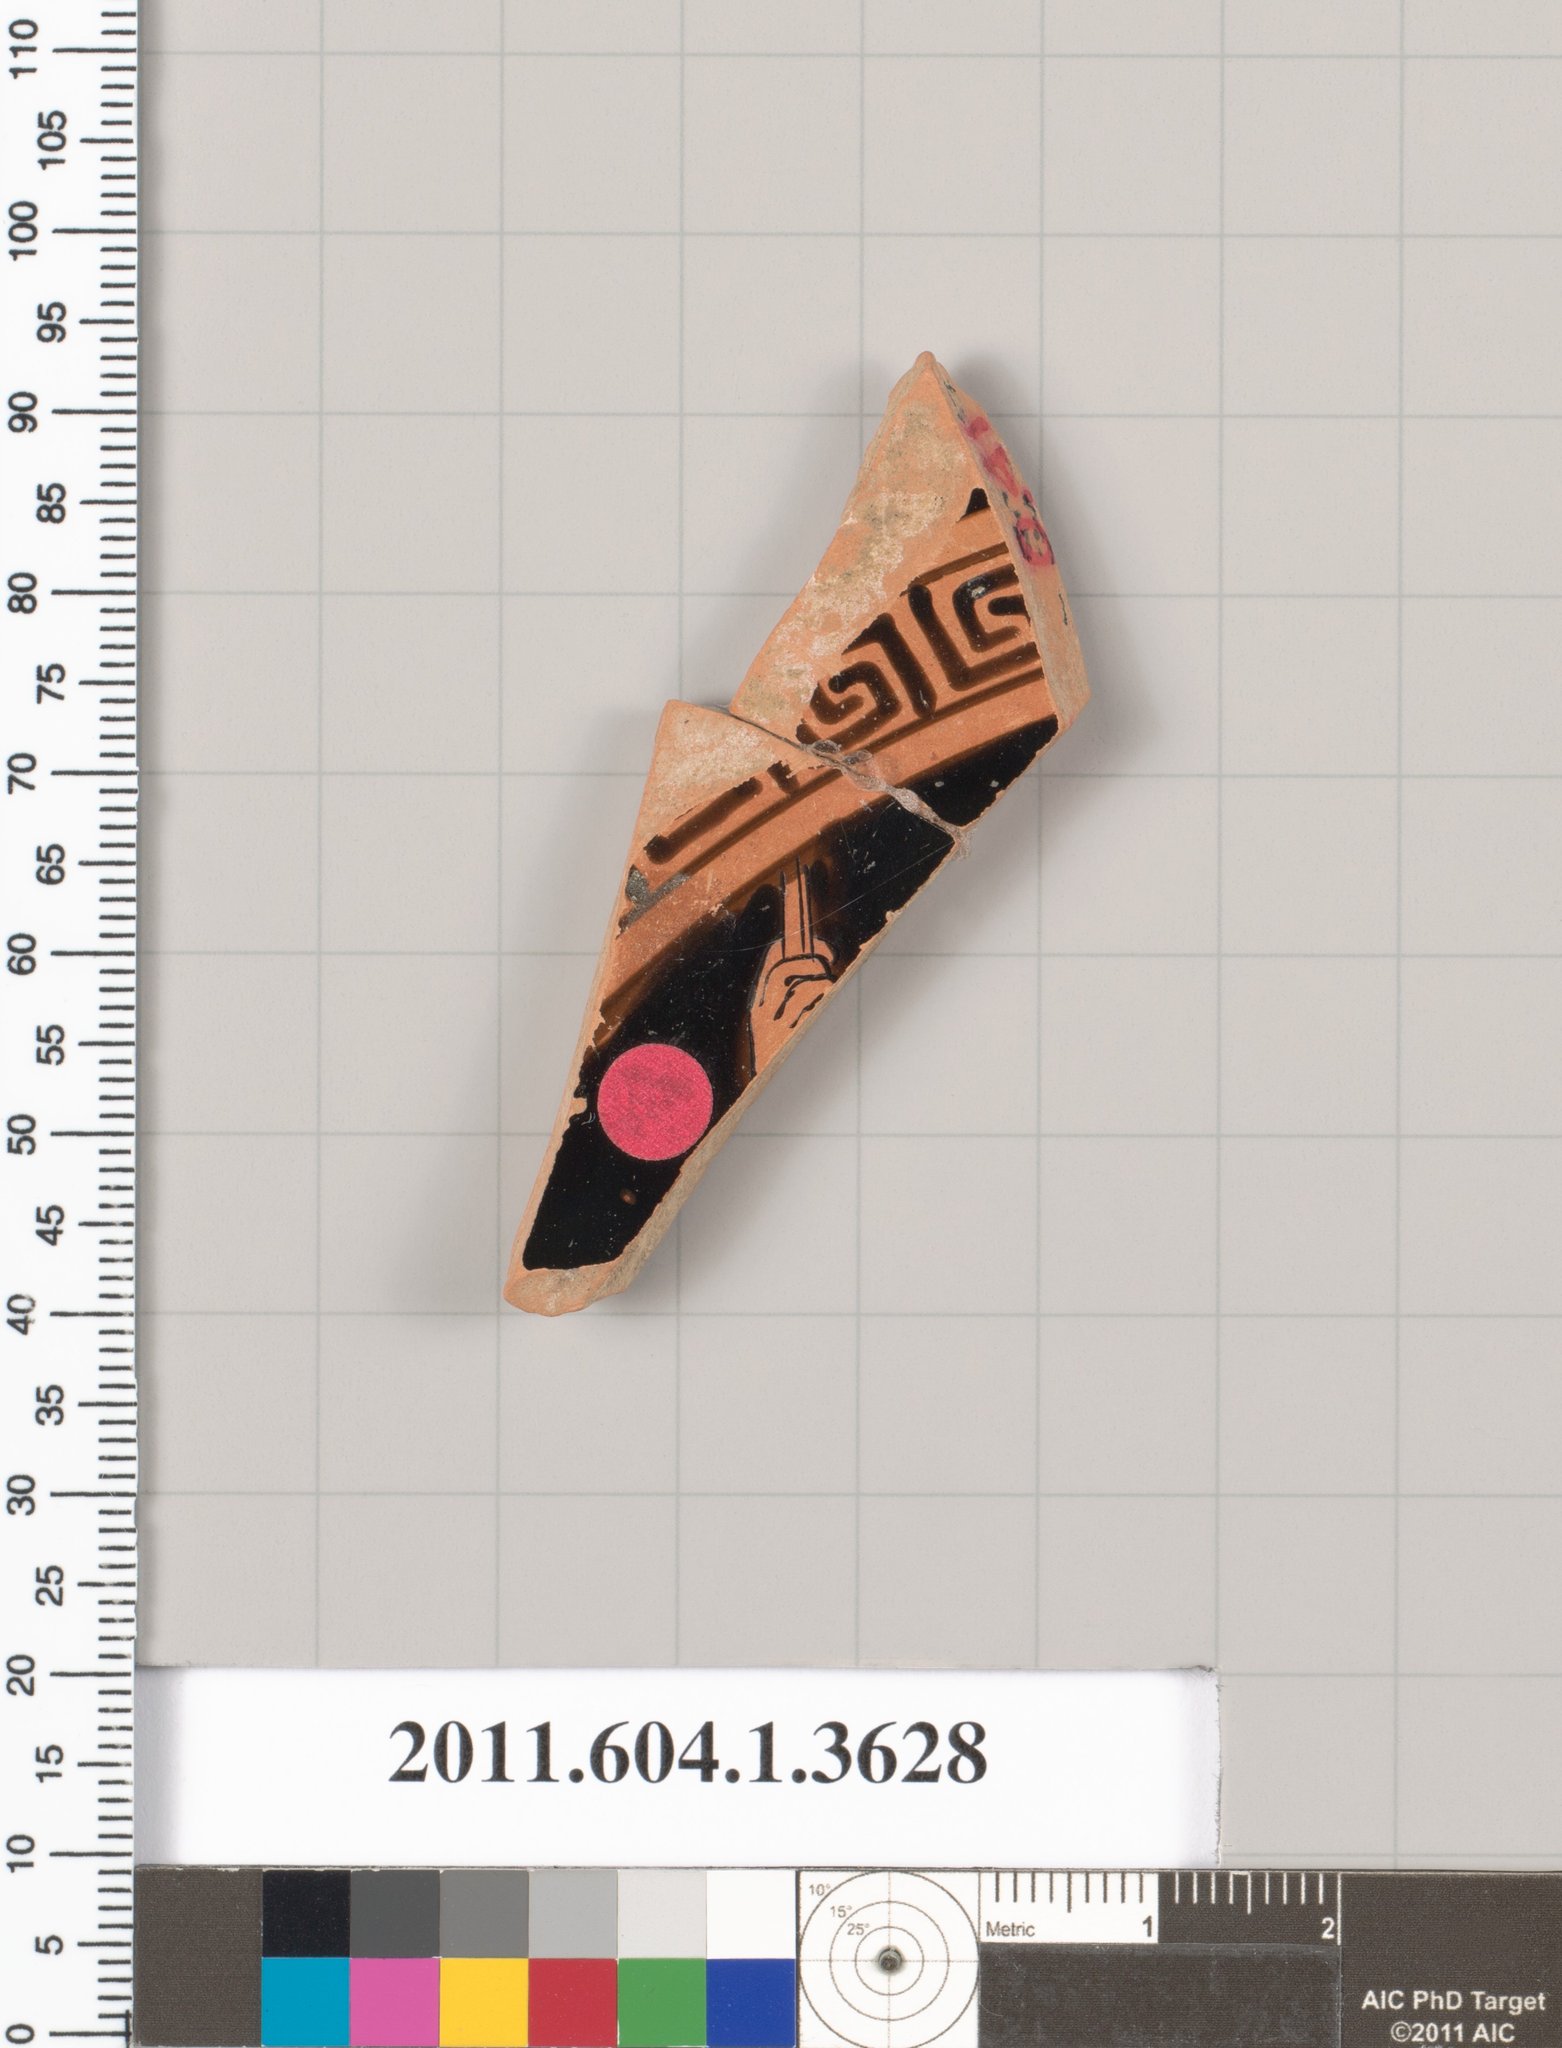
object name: kylix fragment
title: Terracotta fragment of a kylix (drinking cup)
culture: greek, attic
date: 500-476 BCE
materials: terracotta